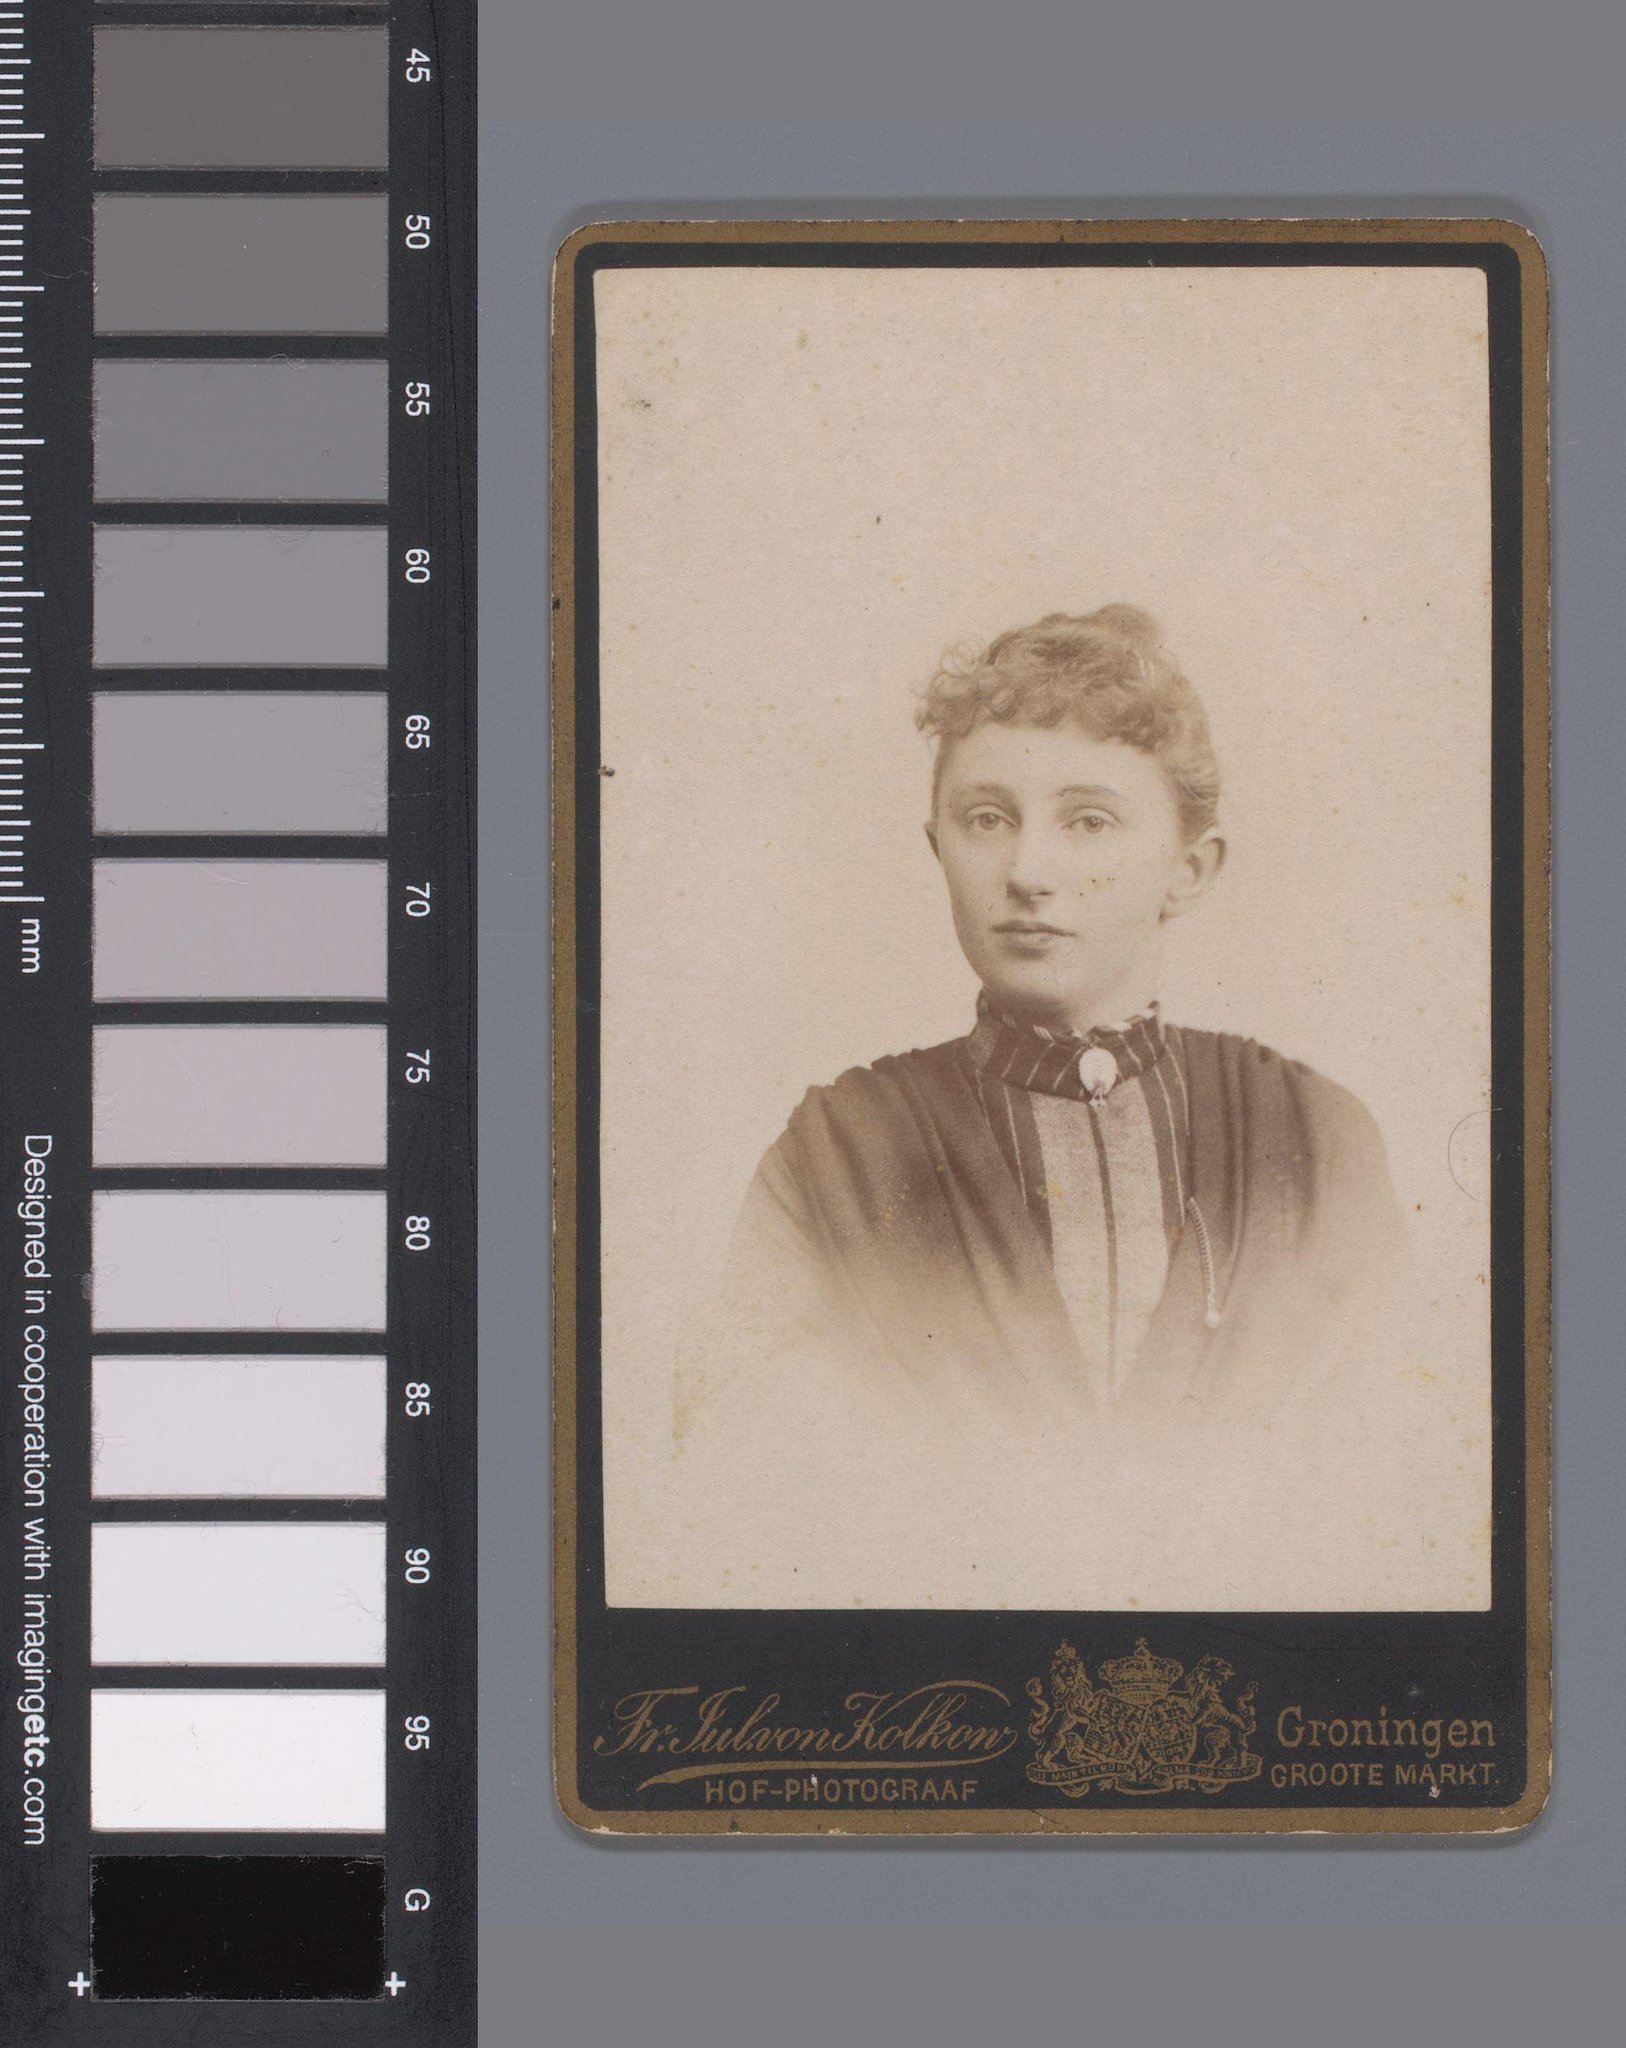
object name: photograph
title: Portret van een onbekende vrouw, aangeduid als Bouwman Wiskia Boerma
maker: friedrich julius von kolkow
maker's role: fotograaf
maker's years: 1839-1914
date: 1884-1896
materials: cardboard, paper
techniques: albumen print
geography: groningen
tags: historical persons - bb - woman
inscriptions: inscription: ‘Bouwman Wiskia Boerma’, inscription: ‘GOUDEN MEDALJE VOOR KUNST EN WETENSCHAP v Z. M. de KONING v WÜRTTEMBERG/ aan het lint der Frederiksorde/ PHILADELPHIA 1876. WIEN 1873./ FR. JUL. VON KOLKOW/ KONINKLIJK NEDERLANDSCH HOF-PHOTOGRAPH/ Silberne Voigtländer Medaille Kunst u Wissenschaft Oldenburg/ en tien zilveren Medaljes op andere Tentoonstellingen./ GRONINGEN/ Groote Markt bij de/ Martinitoorn./ Specialiteit in Vergrootingen.’